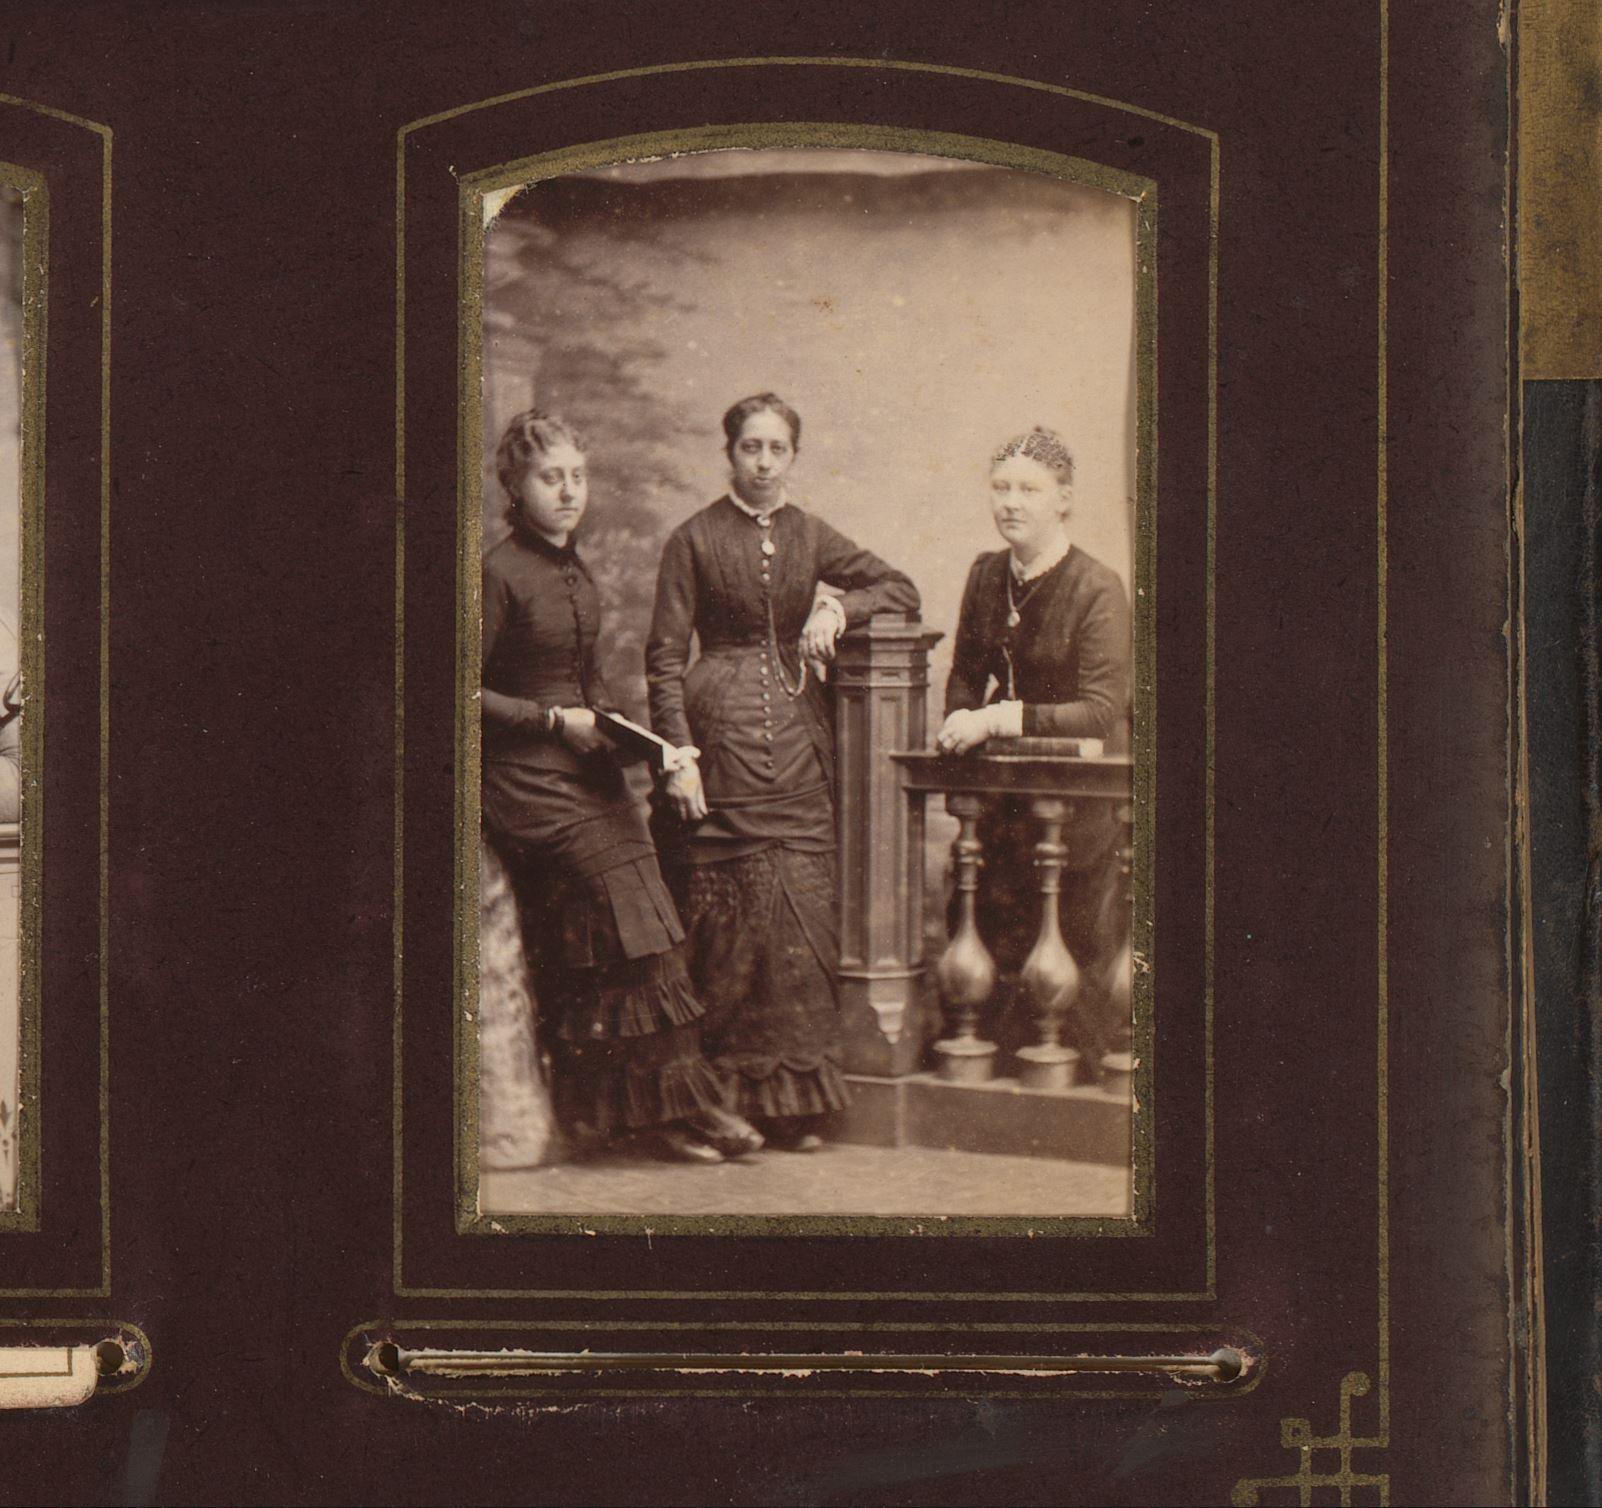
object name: album leaf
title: Portret van drie vrouwen, leunend op een boomstronk en staand bij een balustrade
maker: hendrik boonstoppel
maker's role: fotograaf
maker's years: 1854-1924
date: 1880-1901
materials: cardboard, photographic support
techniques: albumen print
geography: dordrecht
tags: balustrade, adult woman (+ three persons), anonymous historical persons portrayed in a group, in a group-portrait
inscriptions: inscription: ‘Photographie/ H. Boonstoppel/ DORDRECHT/ over het Postkantoor.’